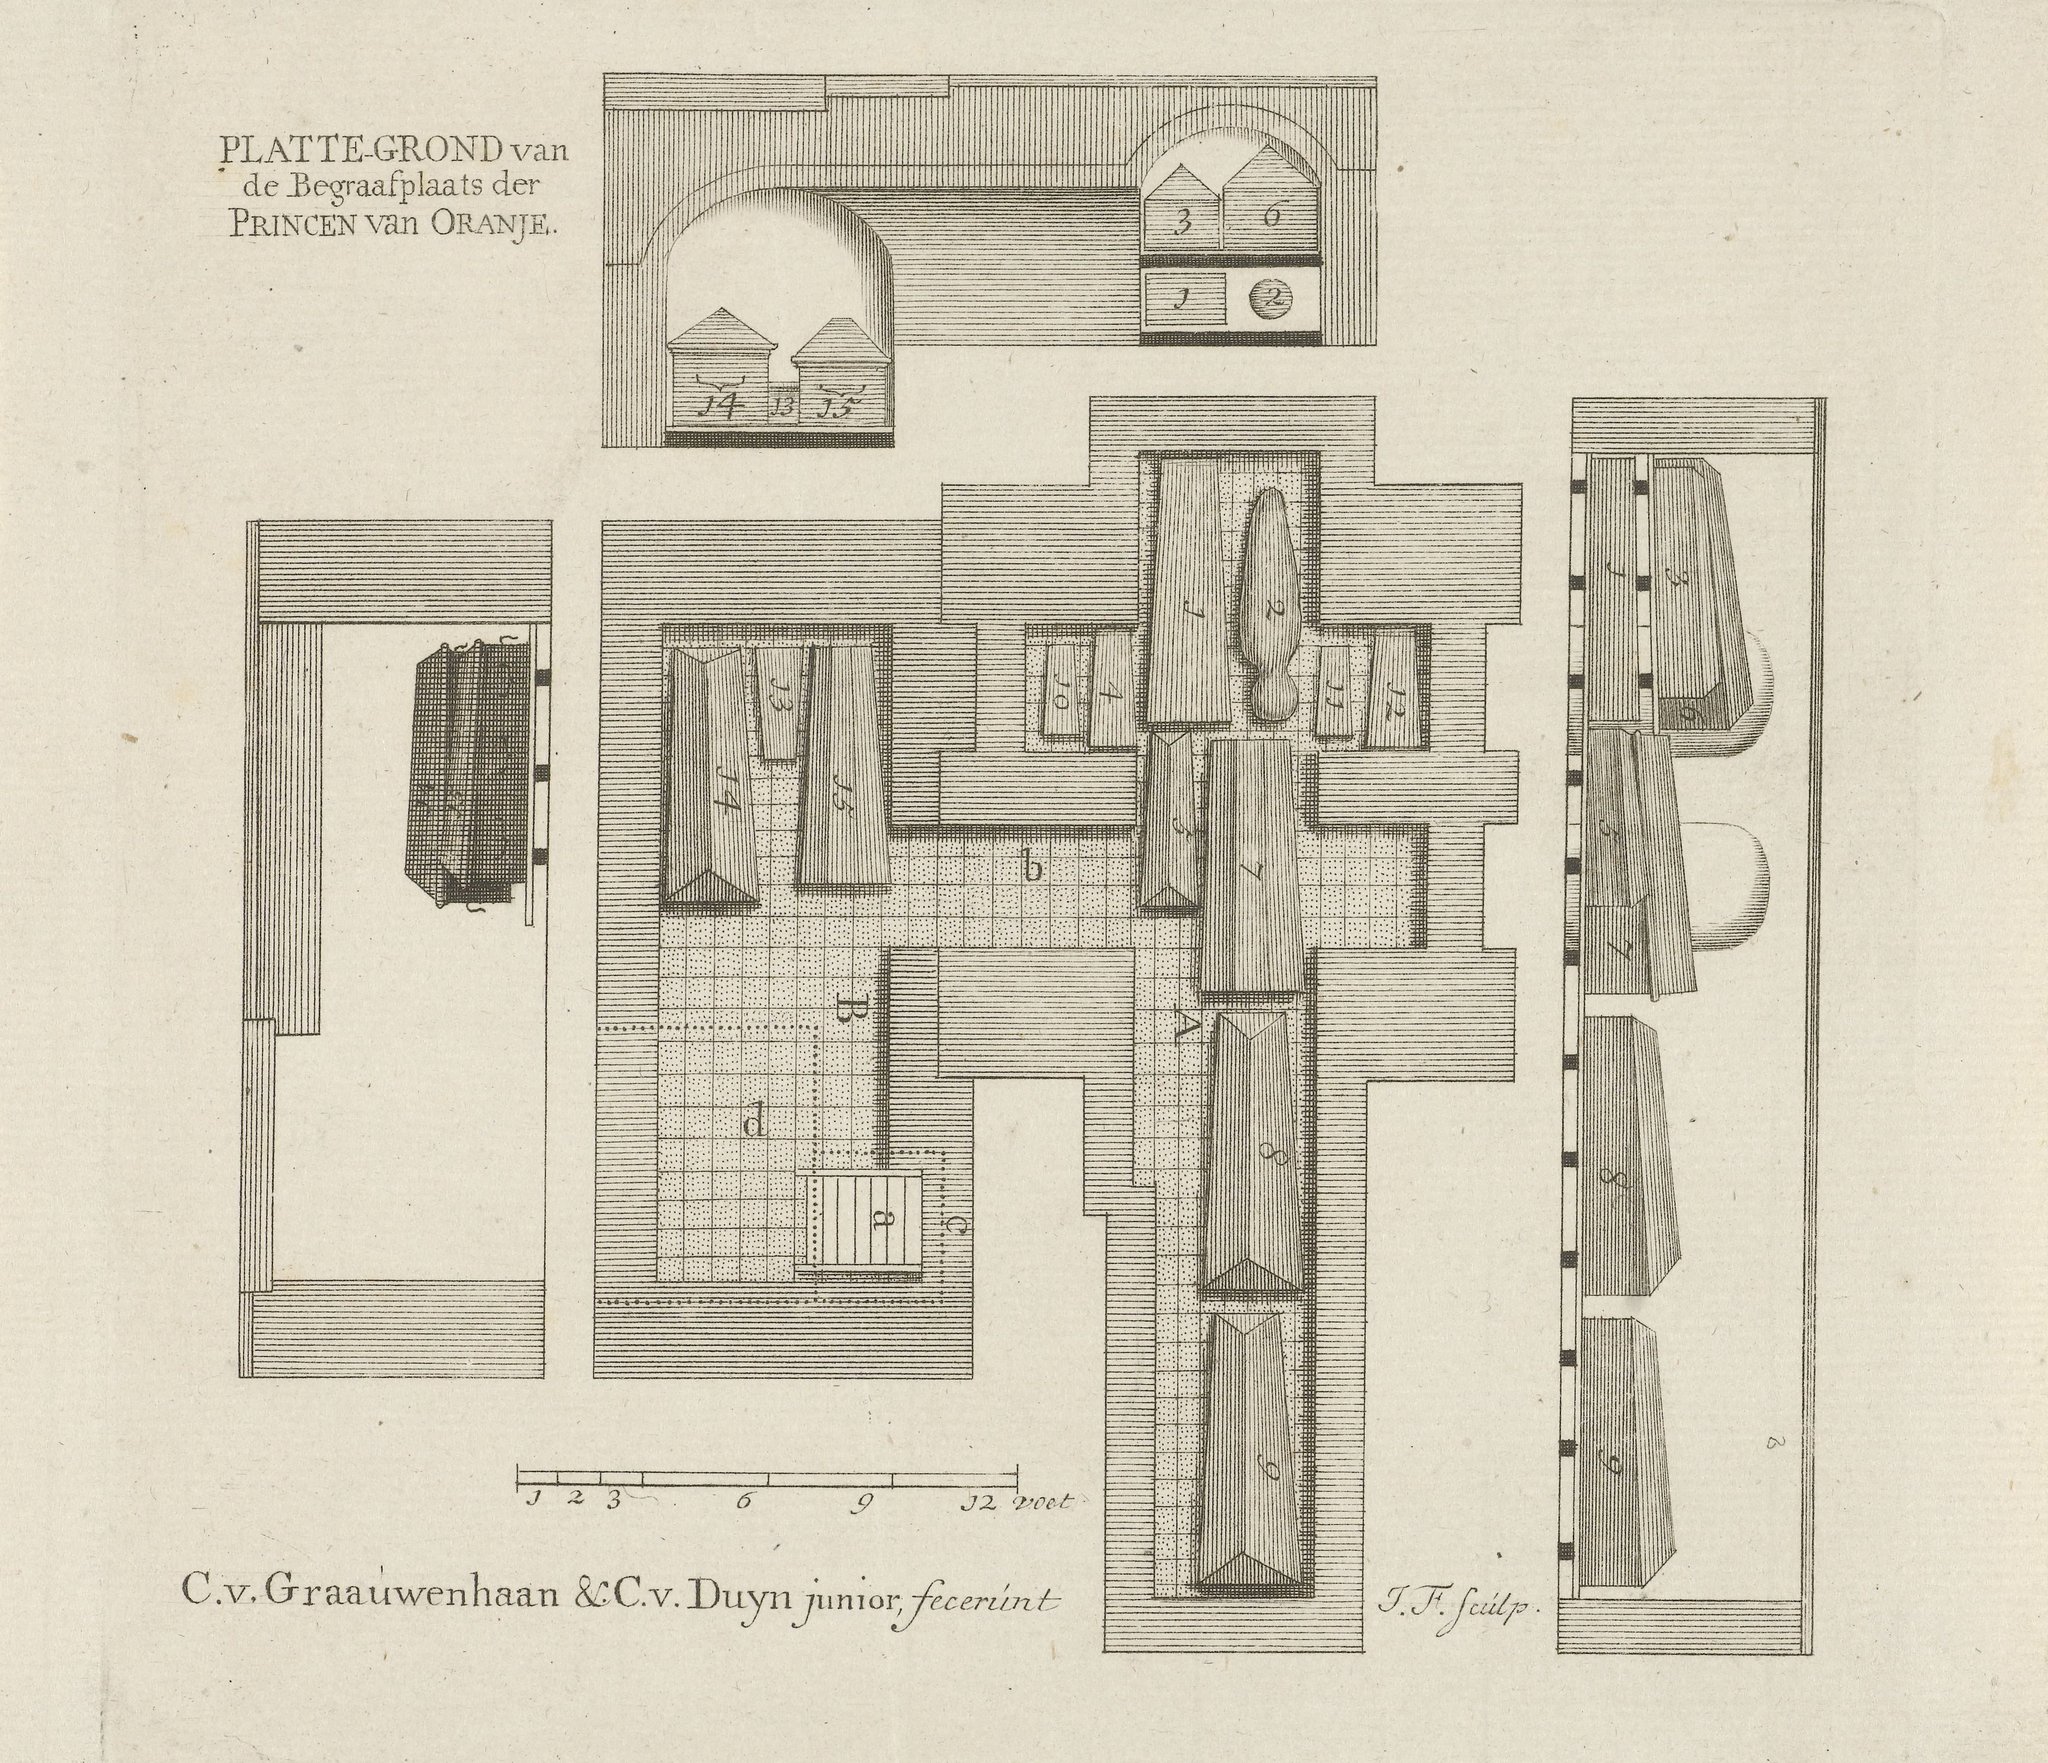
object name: print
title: Plattegrond van de grafkelder van Oranje-Nassau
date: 1743-1790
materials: paper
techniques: etching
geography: delft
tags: parts of church interior (crypt), plan ~ architecture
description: Plattegrond van de grafkelder van Oranje-Nassau onder de Nieuwe Kerk in Delft met de daarin geplaatste kisten, voorzien van nummers en letters.